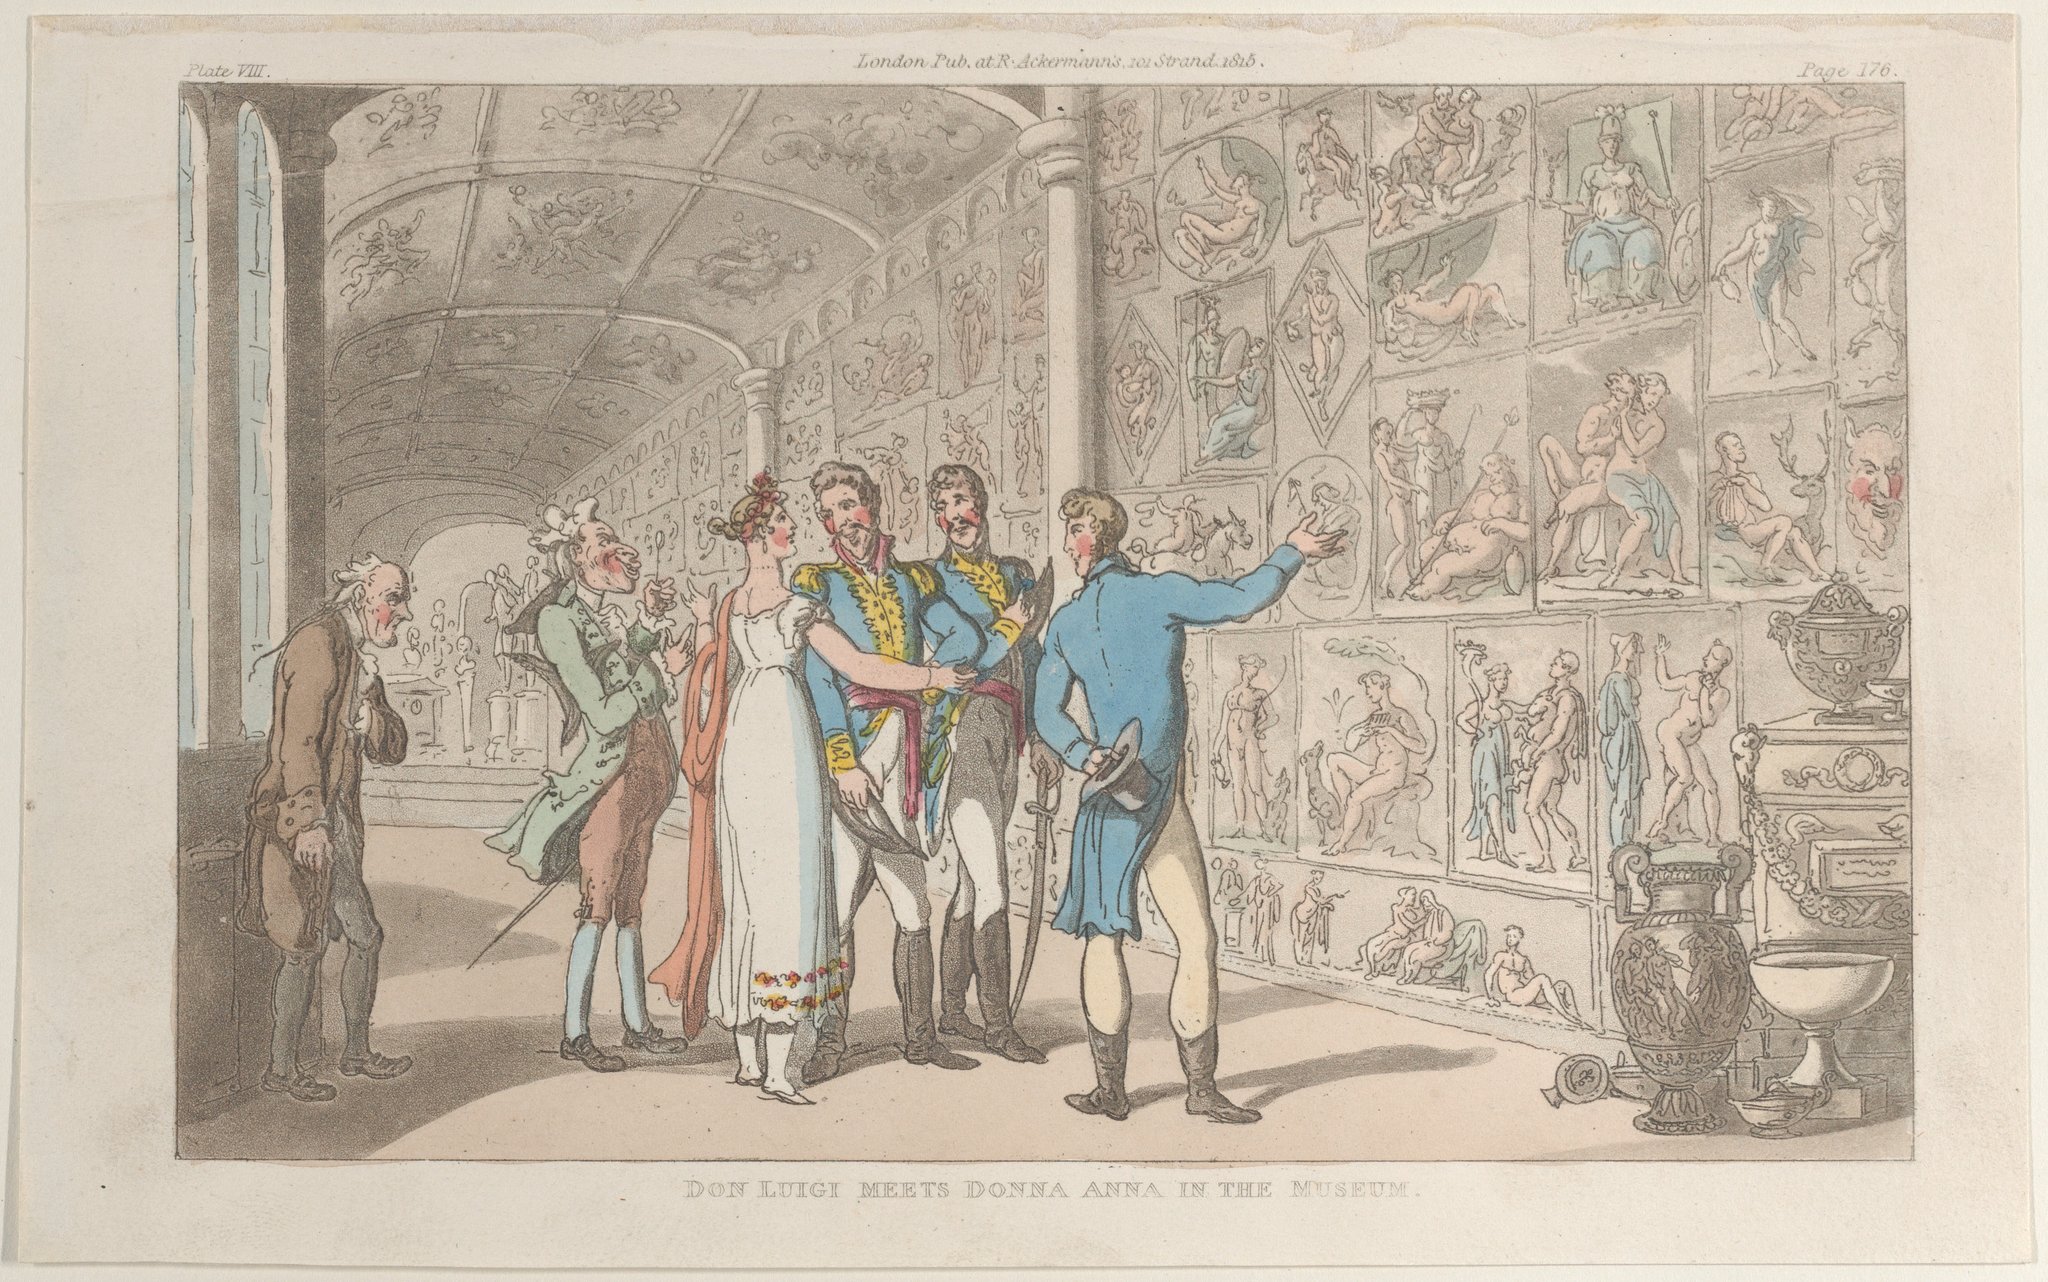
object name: print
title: Don Luigi Meets Donna Anna in the Museum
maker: thomas rowlandson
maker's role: artist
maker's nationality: british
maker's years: 1757-1827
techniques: aquatint, etching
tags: museums,men,women